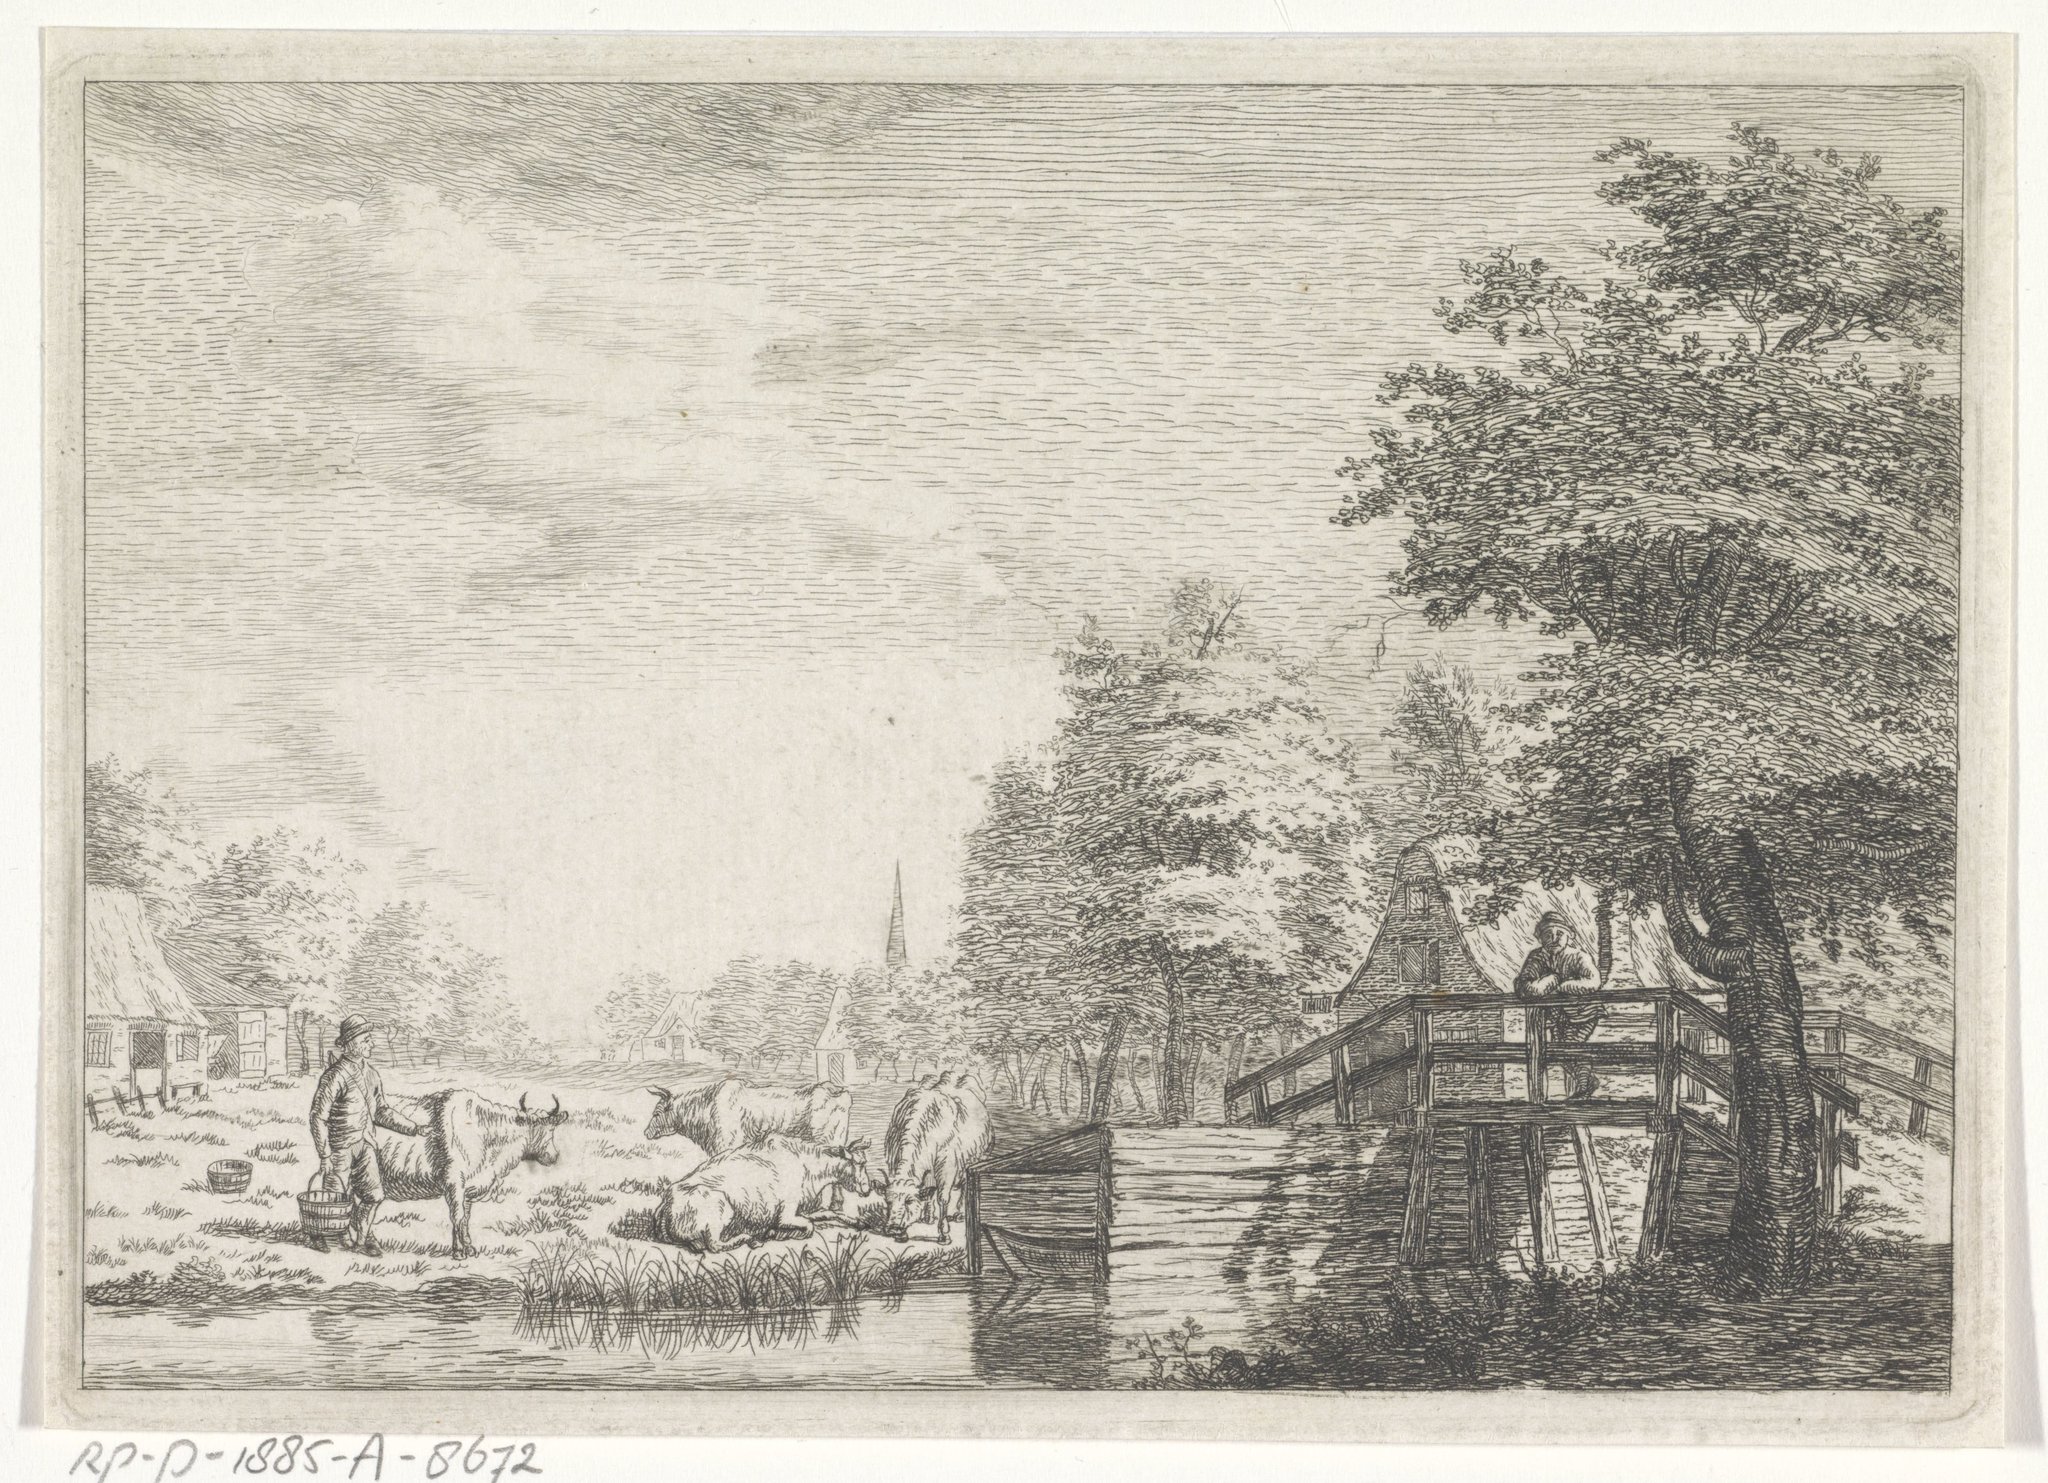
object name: print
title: Landschap met brug en koeien in een weiland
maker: Anonymous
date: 1750-1885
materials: paper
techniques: etching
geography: netherlands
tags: cow, bridge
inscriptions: collector's mark: Lugt 2228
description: Rechts op de voorgrond een man op een brug. Links een boer met emmer in de hand bij koeien in een weiland.